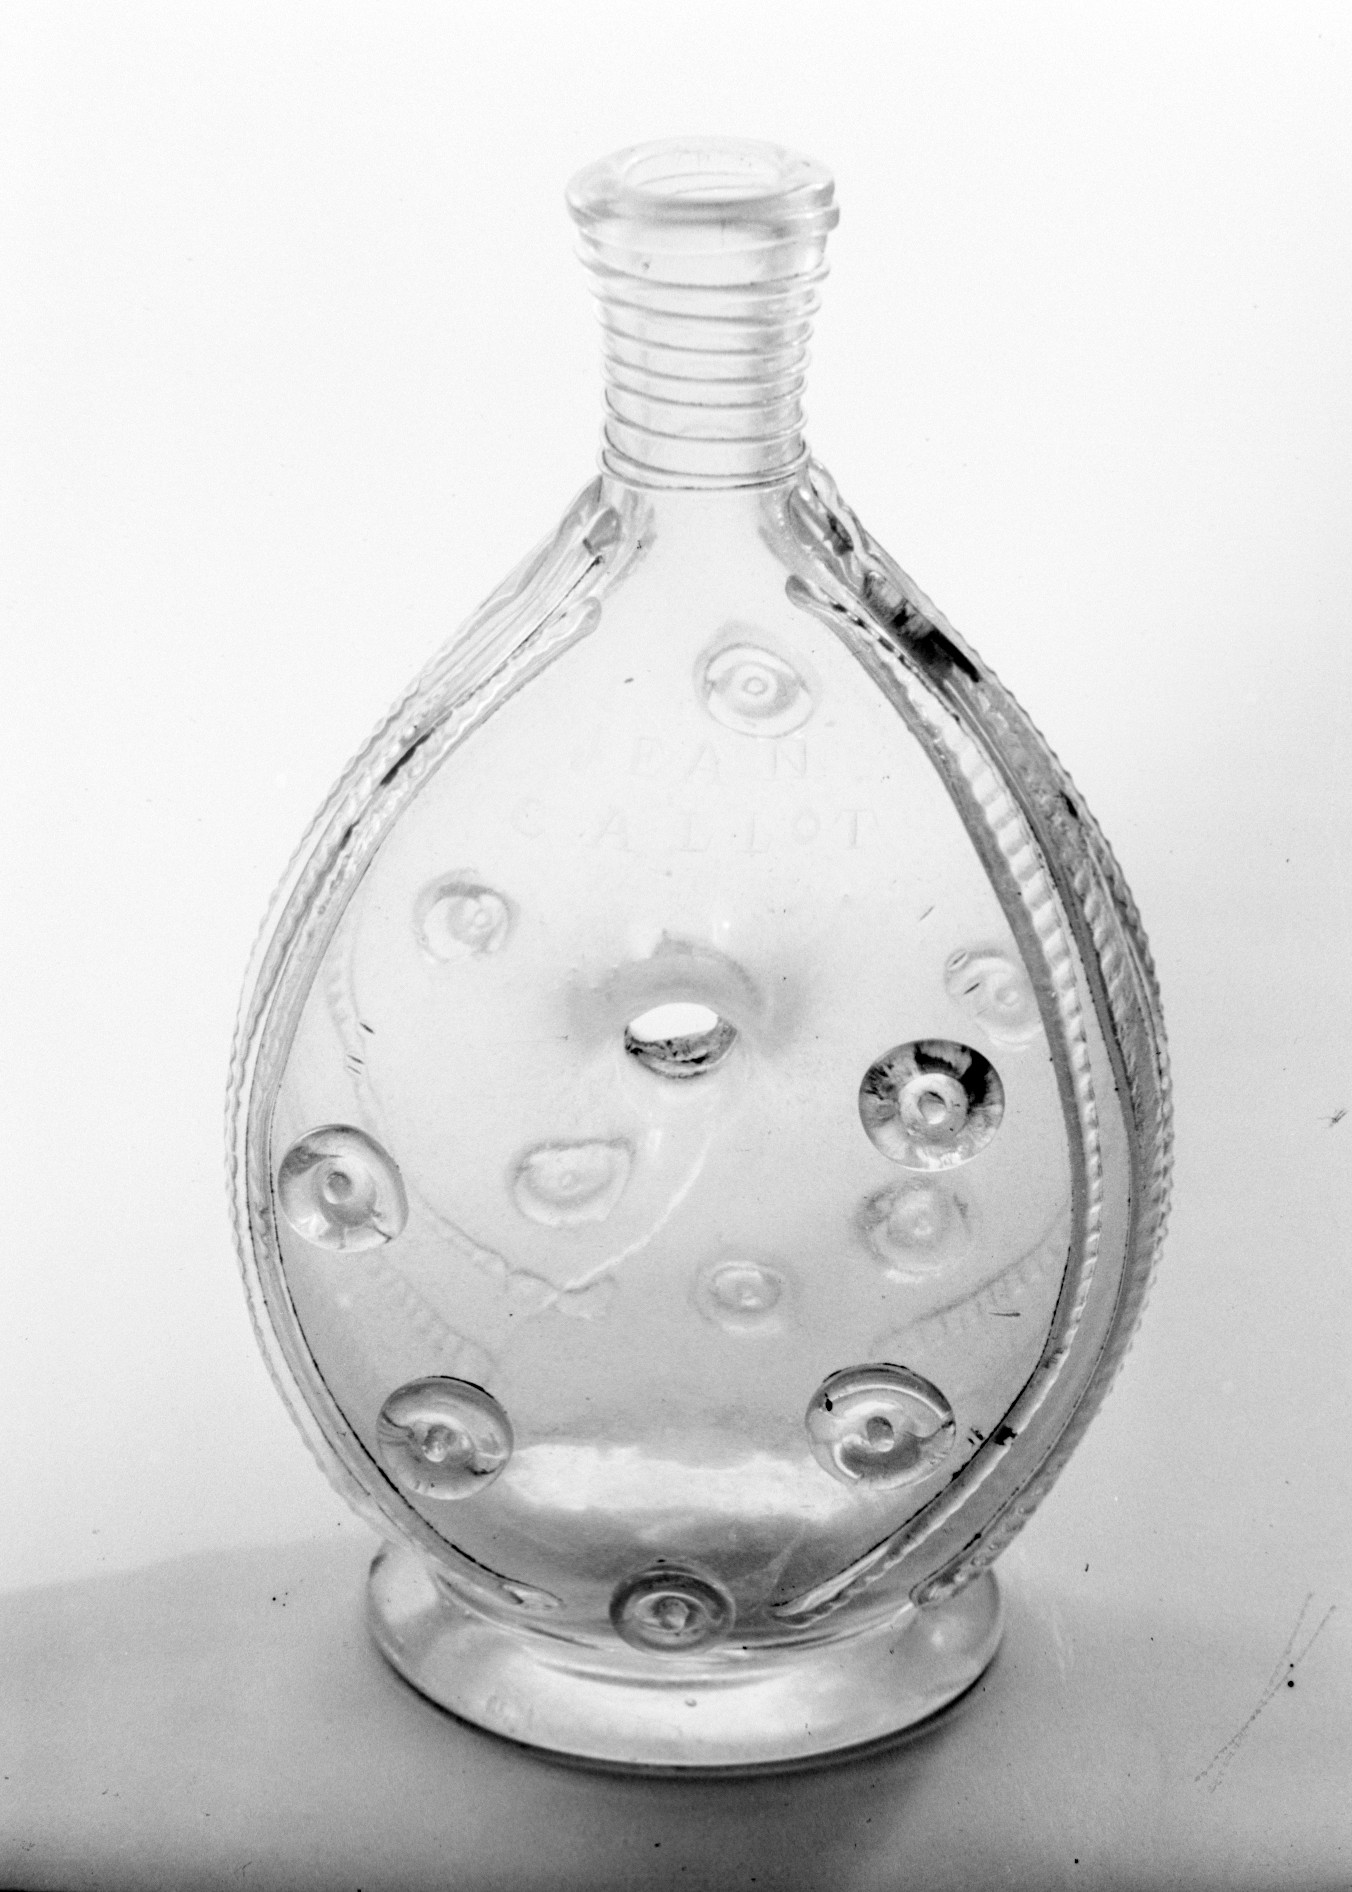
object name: bottle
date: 1701-1800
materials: glass